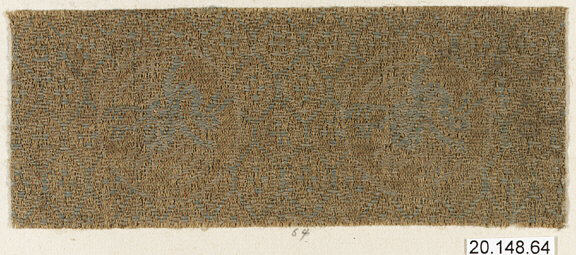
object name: piece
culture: japanese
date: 1401-1500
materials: silk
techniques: compound weave